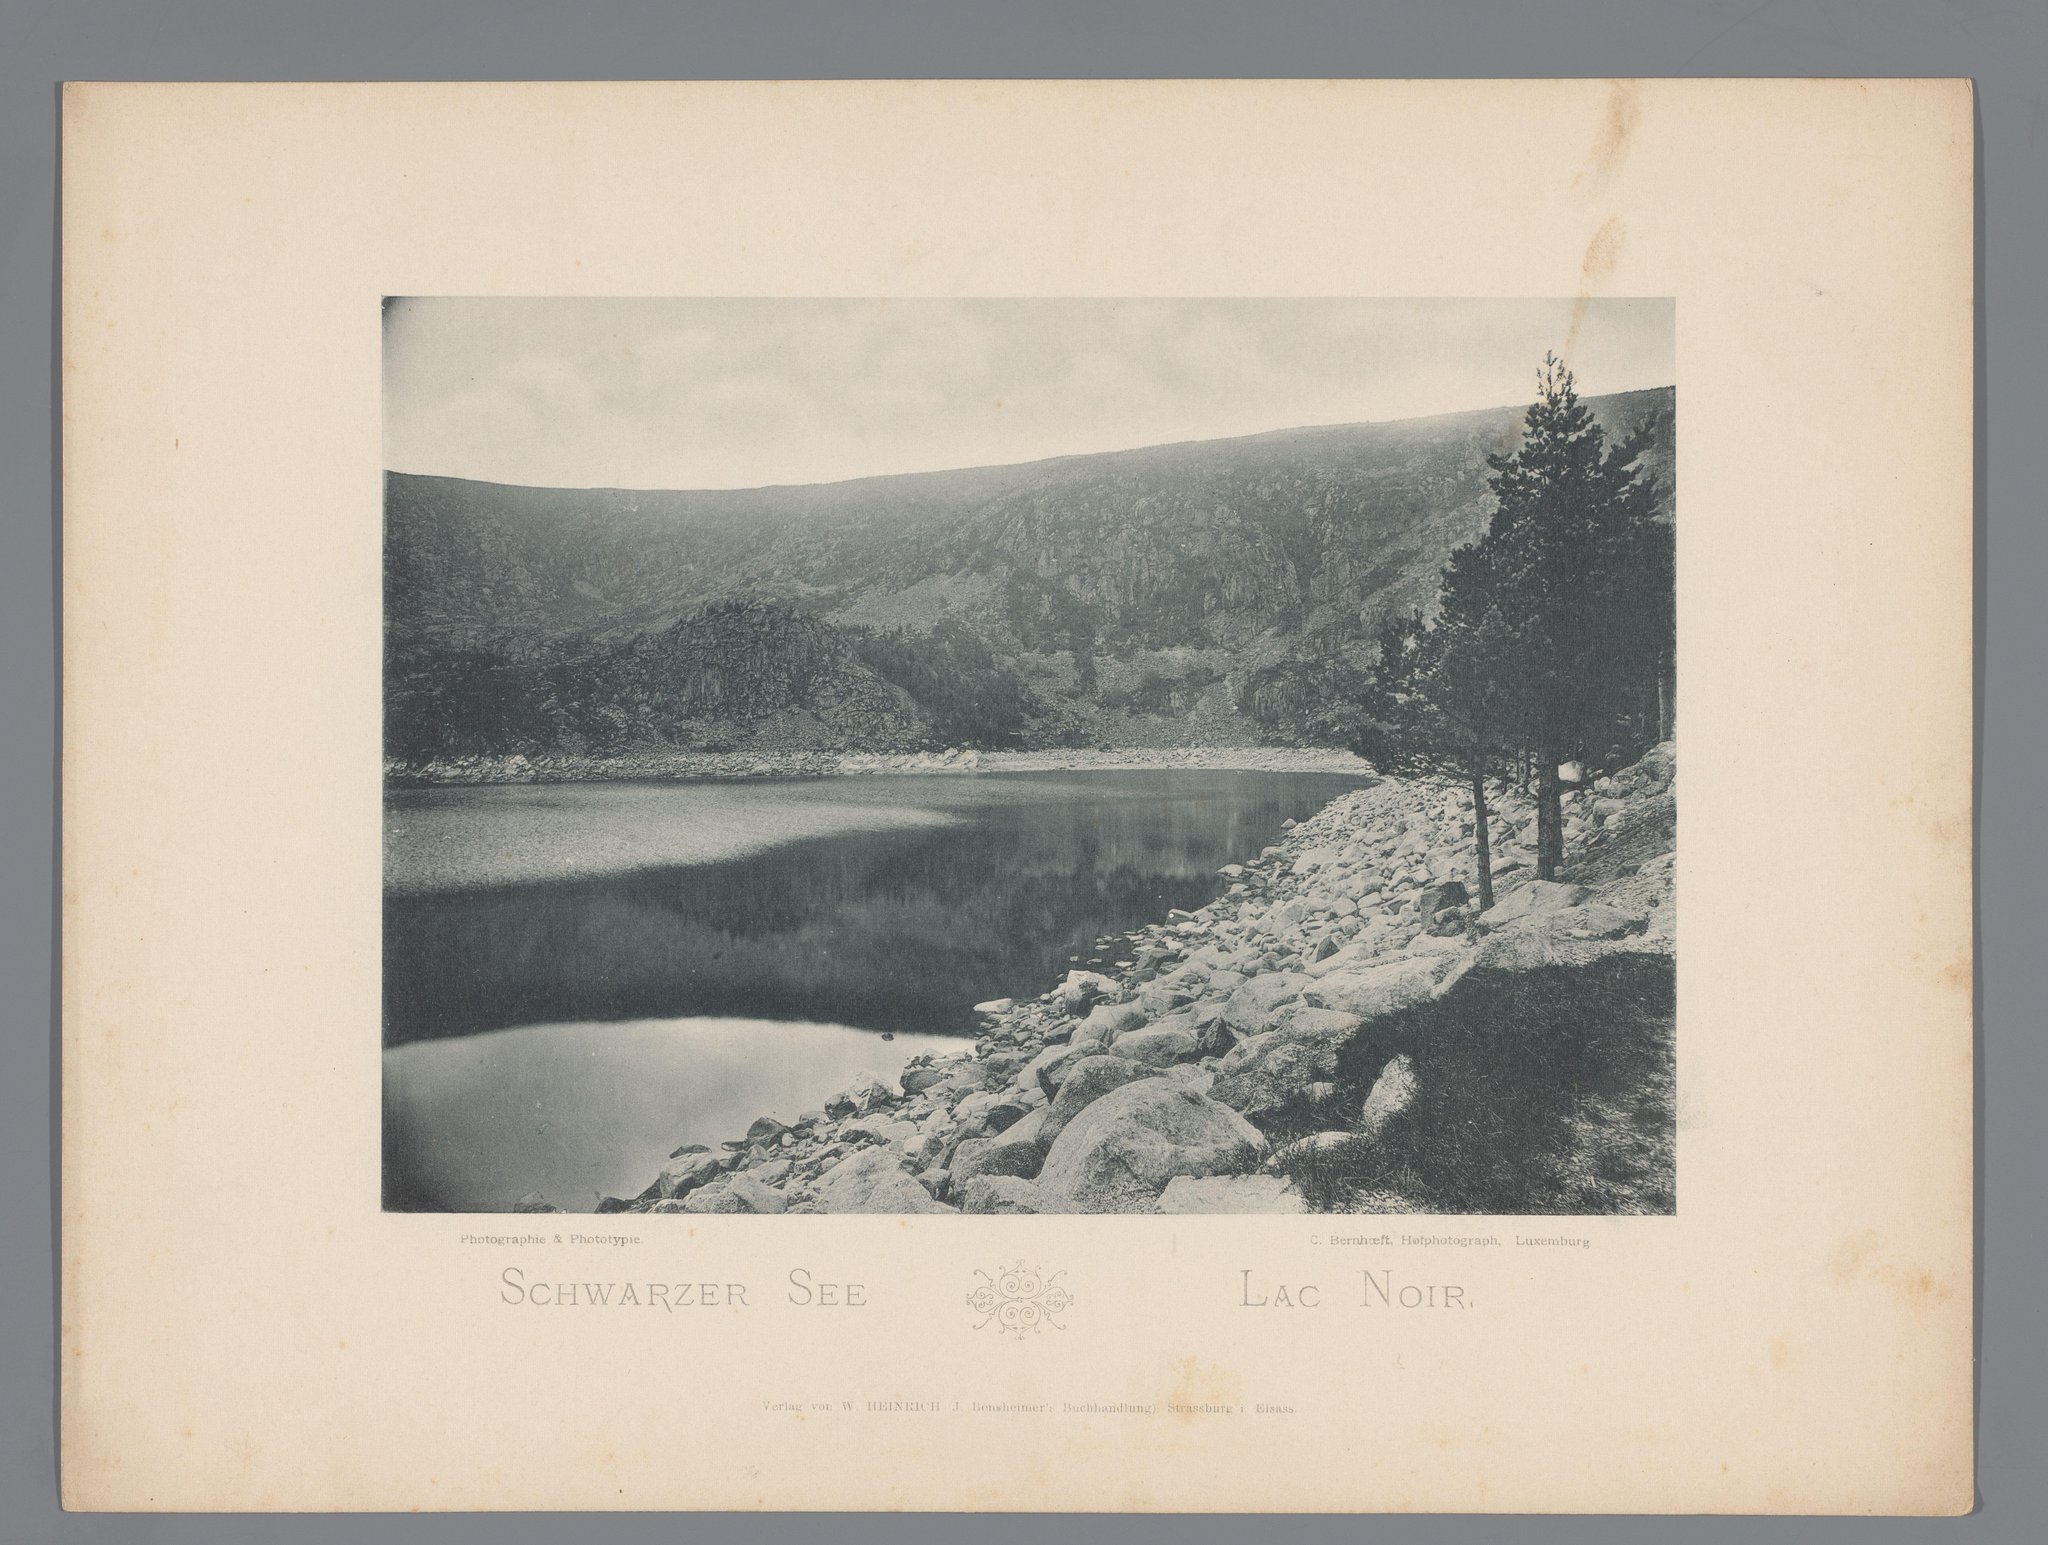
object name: photomechanical print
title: Gezicht op Lac Noir te Orbey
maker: charles bernhoeft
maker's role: publisher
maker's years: 1859-1933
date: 1889-1894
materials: paper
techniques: photograph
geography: straatsburg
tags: lake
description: Deze prent maakt deel uit van een omslag met 100 prenten.